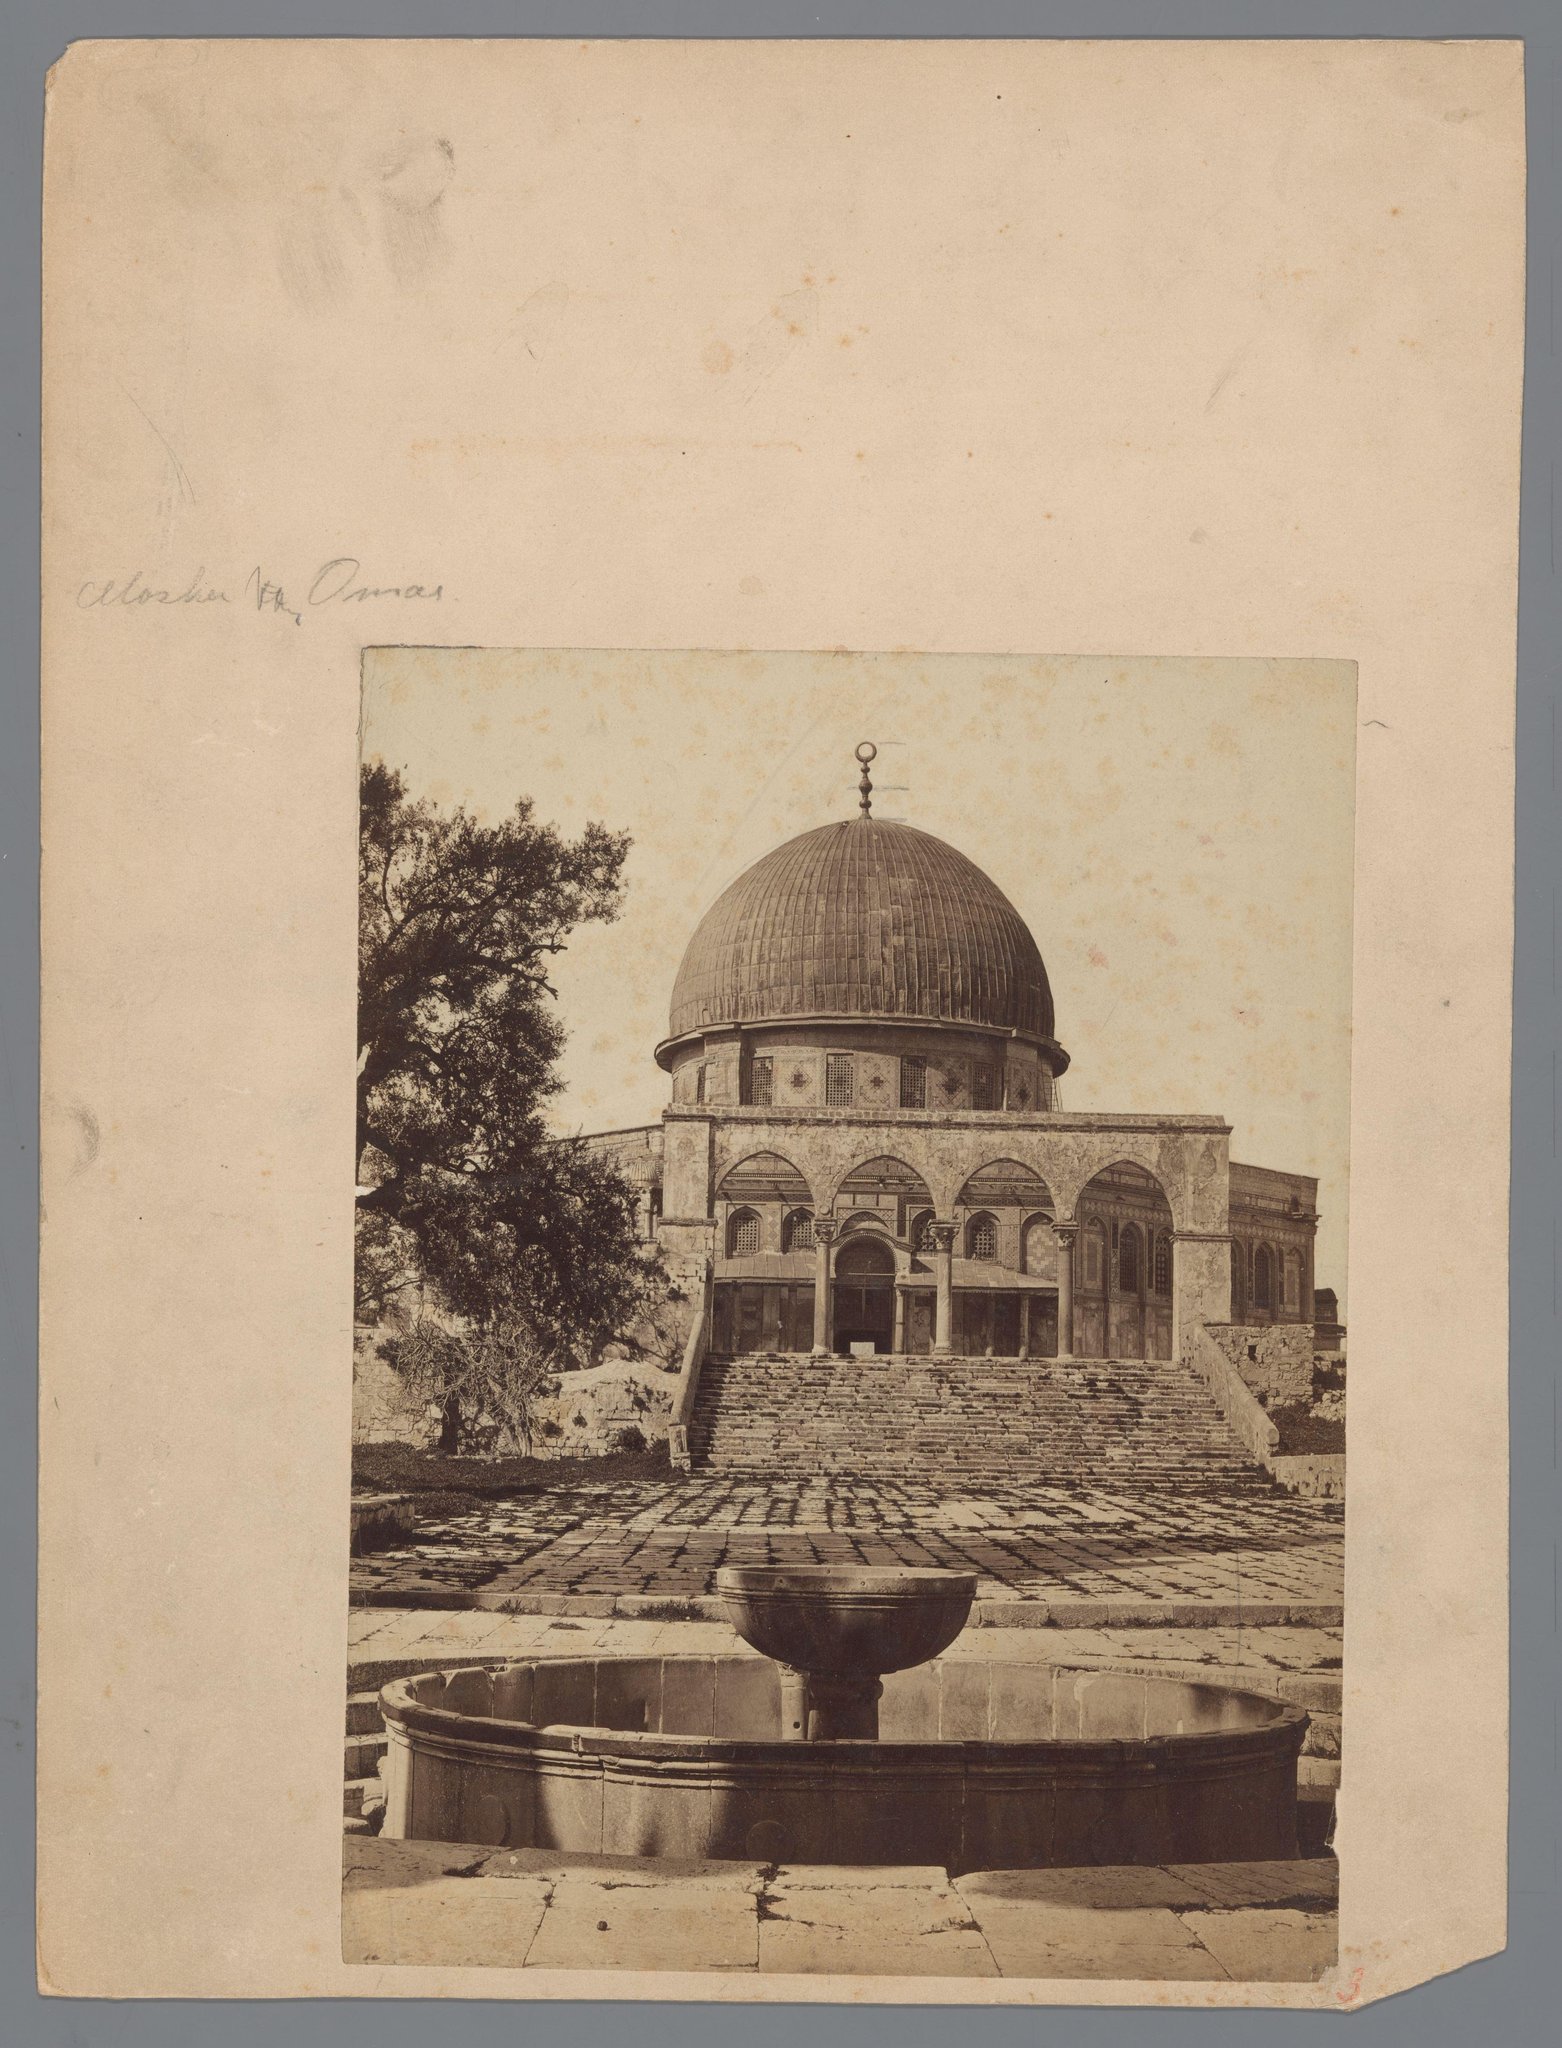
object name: photograph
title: Moskee van Omar.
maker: Anonymous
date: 1875-1900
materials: cardboard, photographic support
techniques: albumen print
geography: jerusalem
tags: temple, shrine ~ non-christian religions, dome ~ architecture, utilitarian, public pump or water fountain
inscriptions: collector's mark: Lugt 3937, inscription: ‘Omar Moskee Jerusalem’